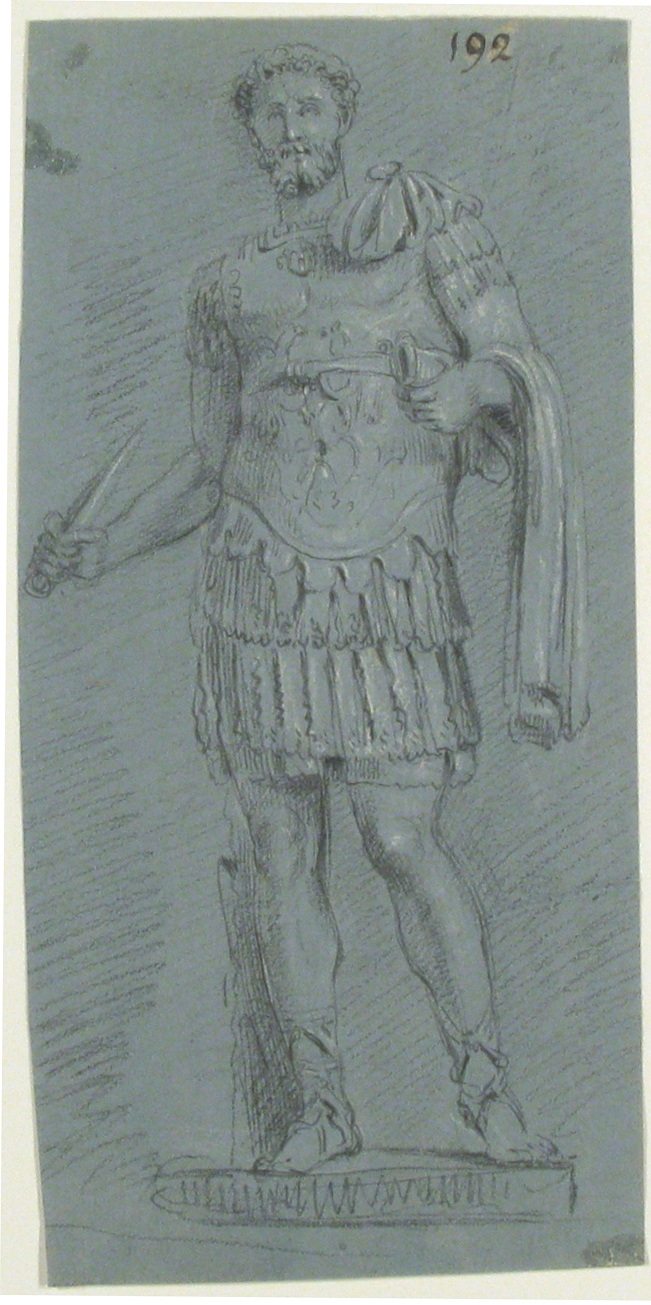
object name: drawing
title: Statue of Warrior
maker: anonymous, french, 18th century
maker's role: artist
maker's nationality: french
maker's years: 1700-1800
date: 1701-1800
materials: chalk, graphite, paper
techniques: heightening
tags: soldiers,daggers,men